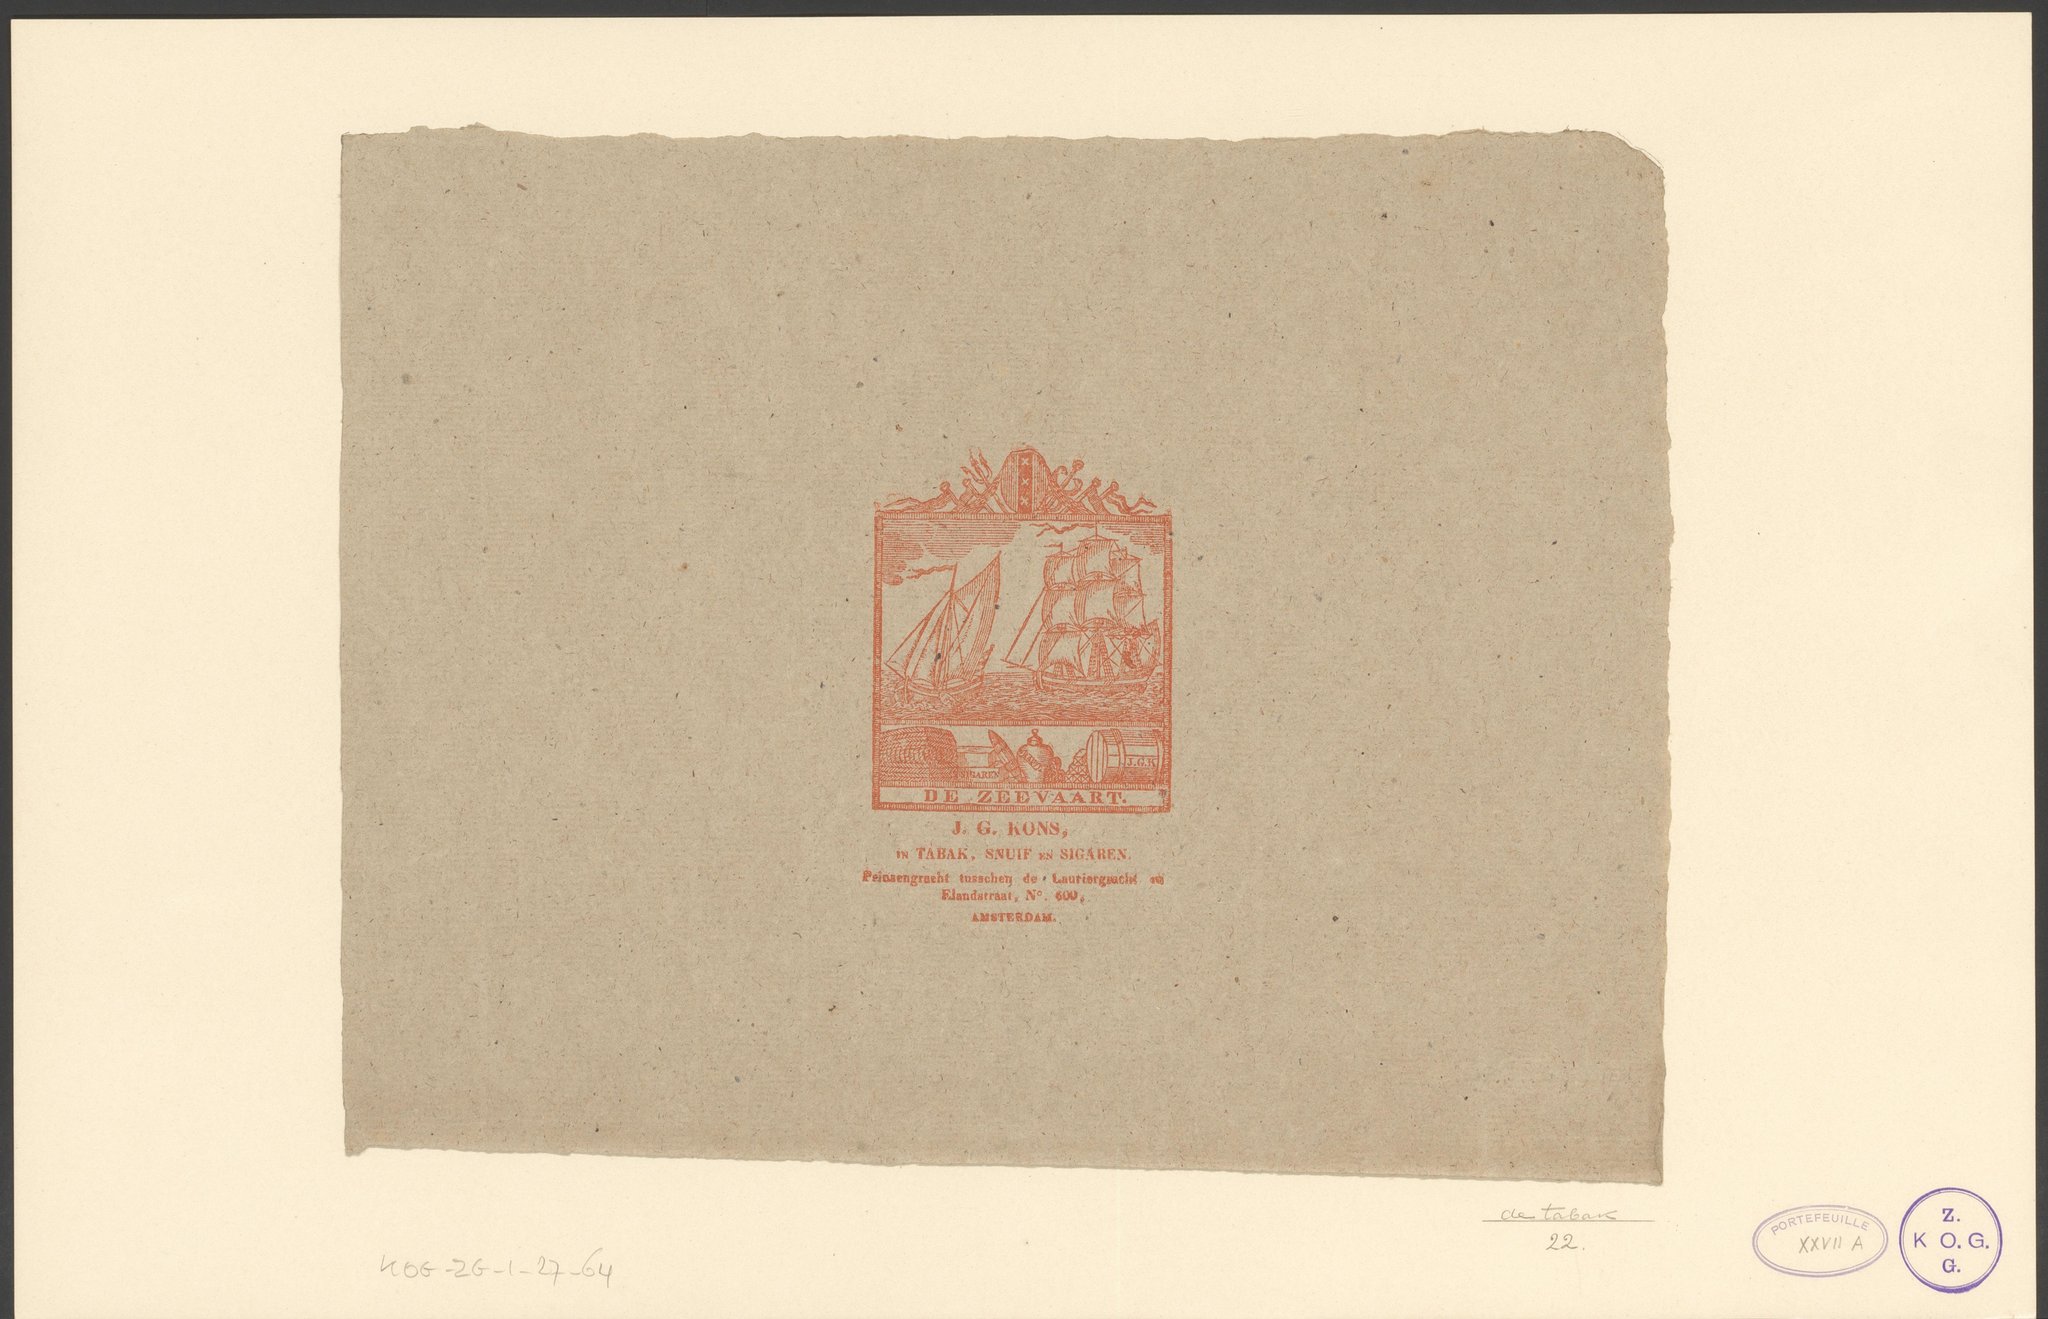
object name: label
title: Etiket voor tabaksverpakking van J.G. Kons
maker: Anonymous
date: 1800-1850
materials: paper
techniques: letterpress printing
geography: netherlands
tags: sailing-ship, sailing-boat, tobacco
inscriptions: collector's mark, collector's mark: Lugt 1641